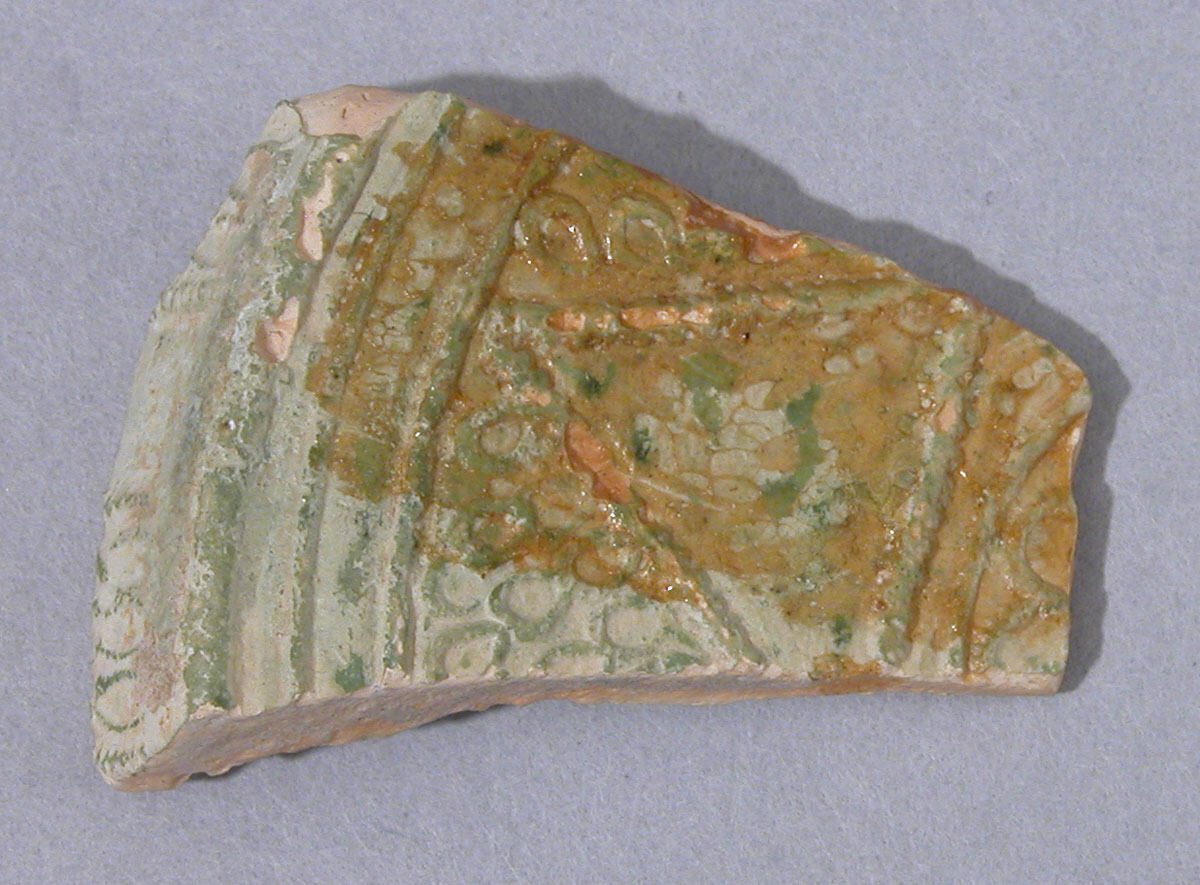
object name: fragment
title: Ceramic Fragment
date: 801-900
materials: earthenware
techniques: glazing, molding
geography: saudi arabia